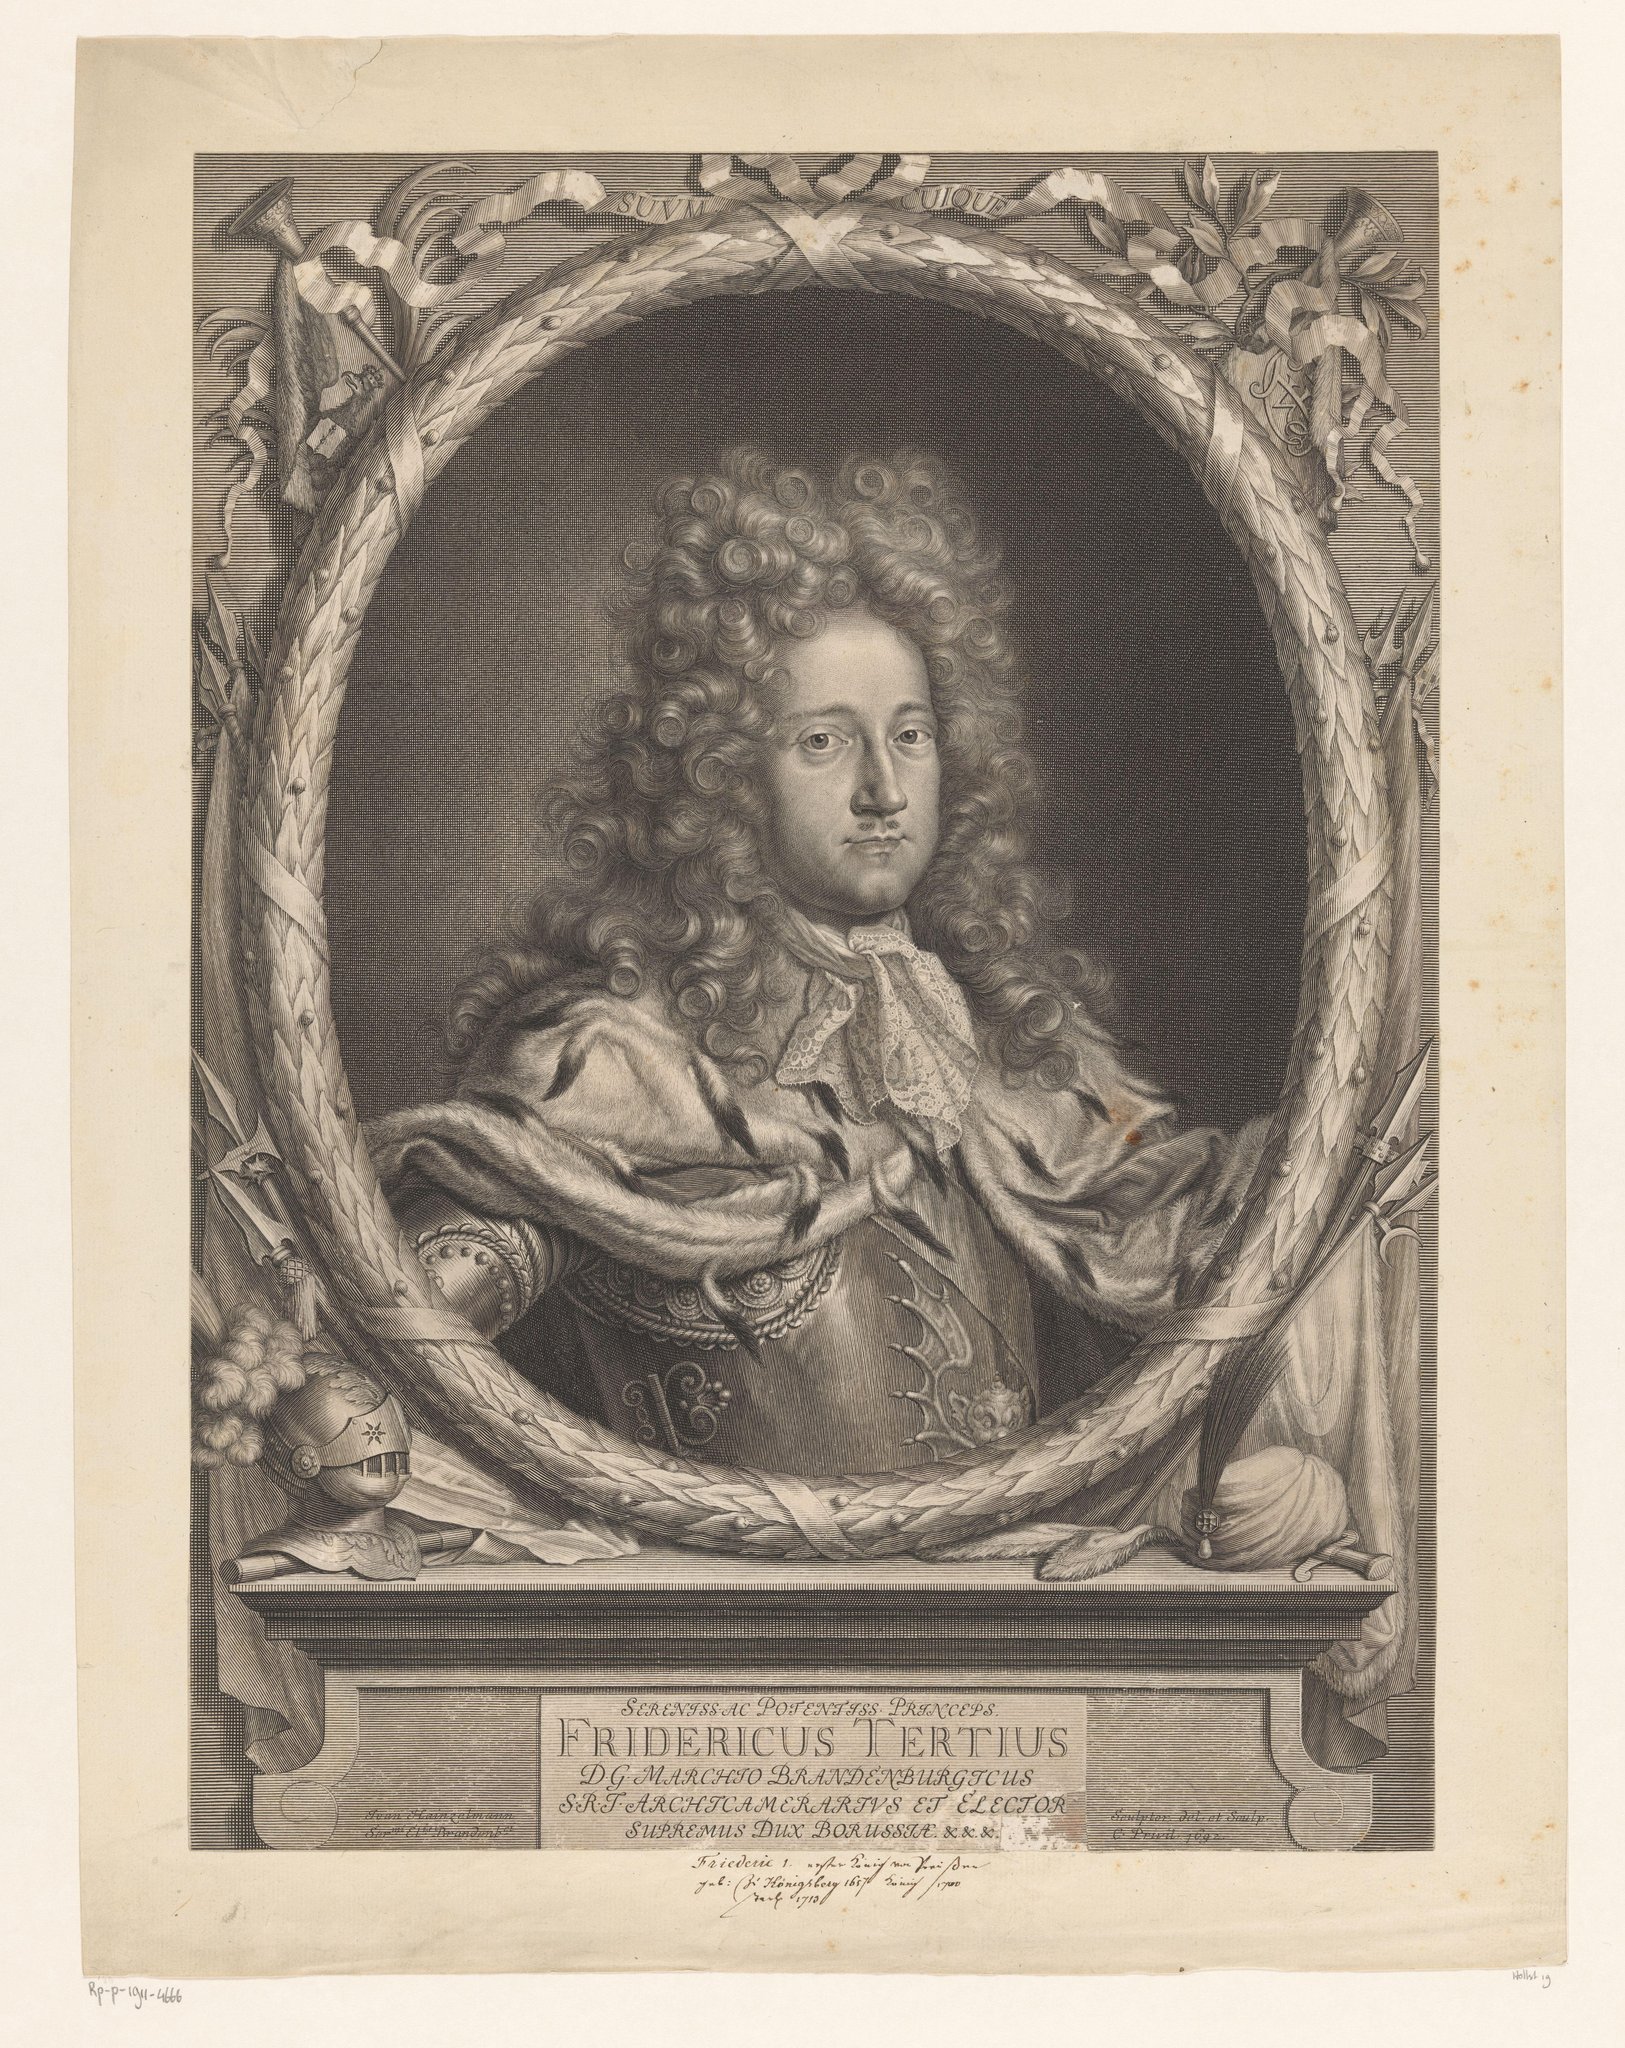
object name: print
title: Portret van Frederik I koning van Pruisen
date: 1692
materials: paper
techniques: engraving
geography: brandenburg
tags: berlin, frederik i koning van pruisen, trees: laurel (branch, stick), historical persons, ruler, sovereign, symbols, allegories of war; 'guerra' (ripa), insignia and symbols of sovereignty (crown, diadem, sceptre, orb, seal, standard, cloak, pectoral)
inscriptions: inscription: ‘Amann’ Lugt 9, collector's mark: Lugt 2228